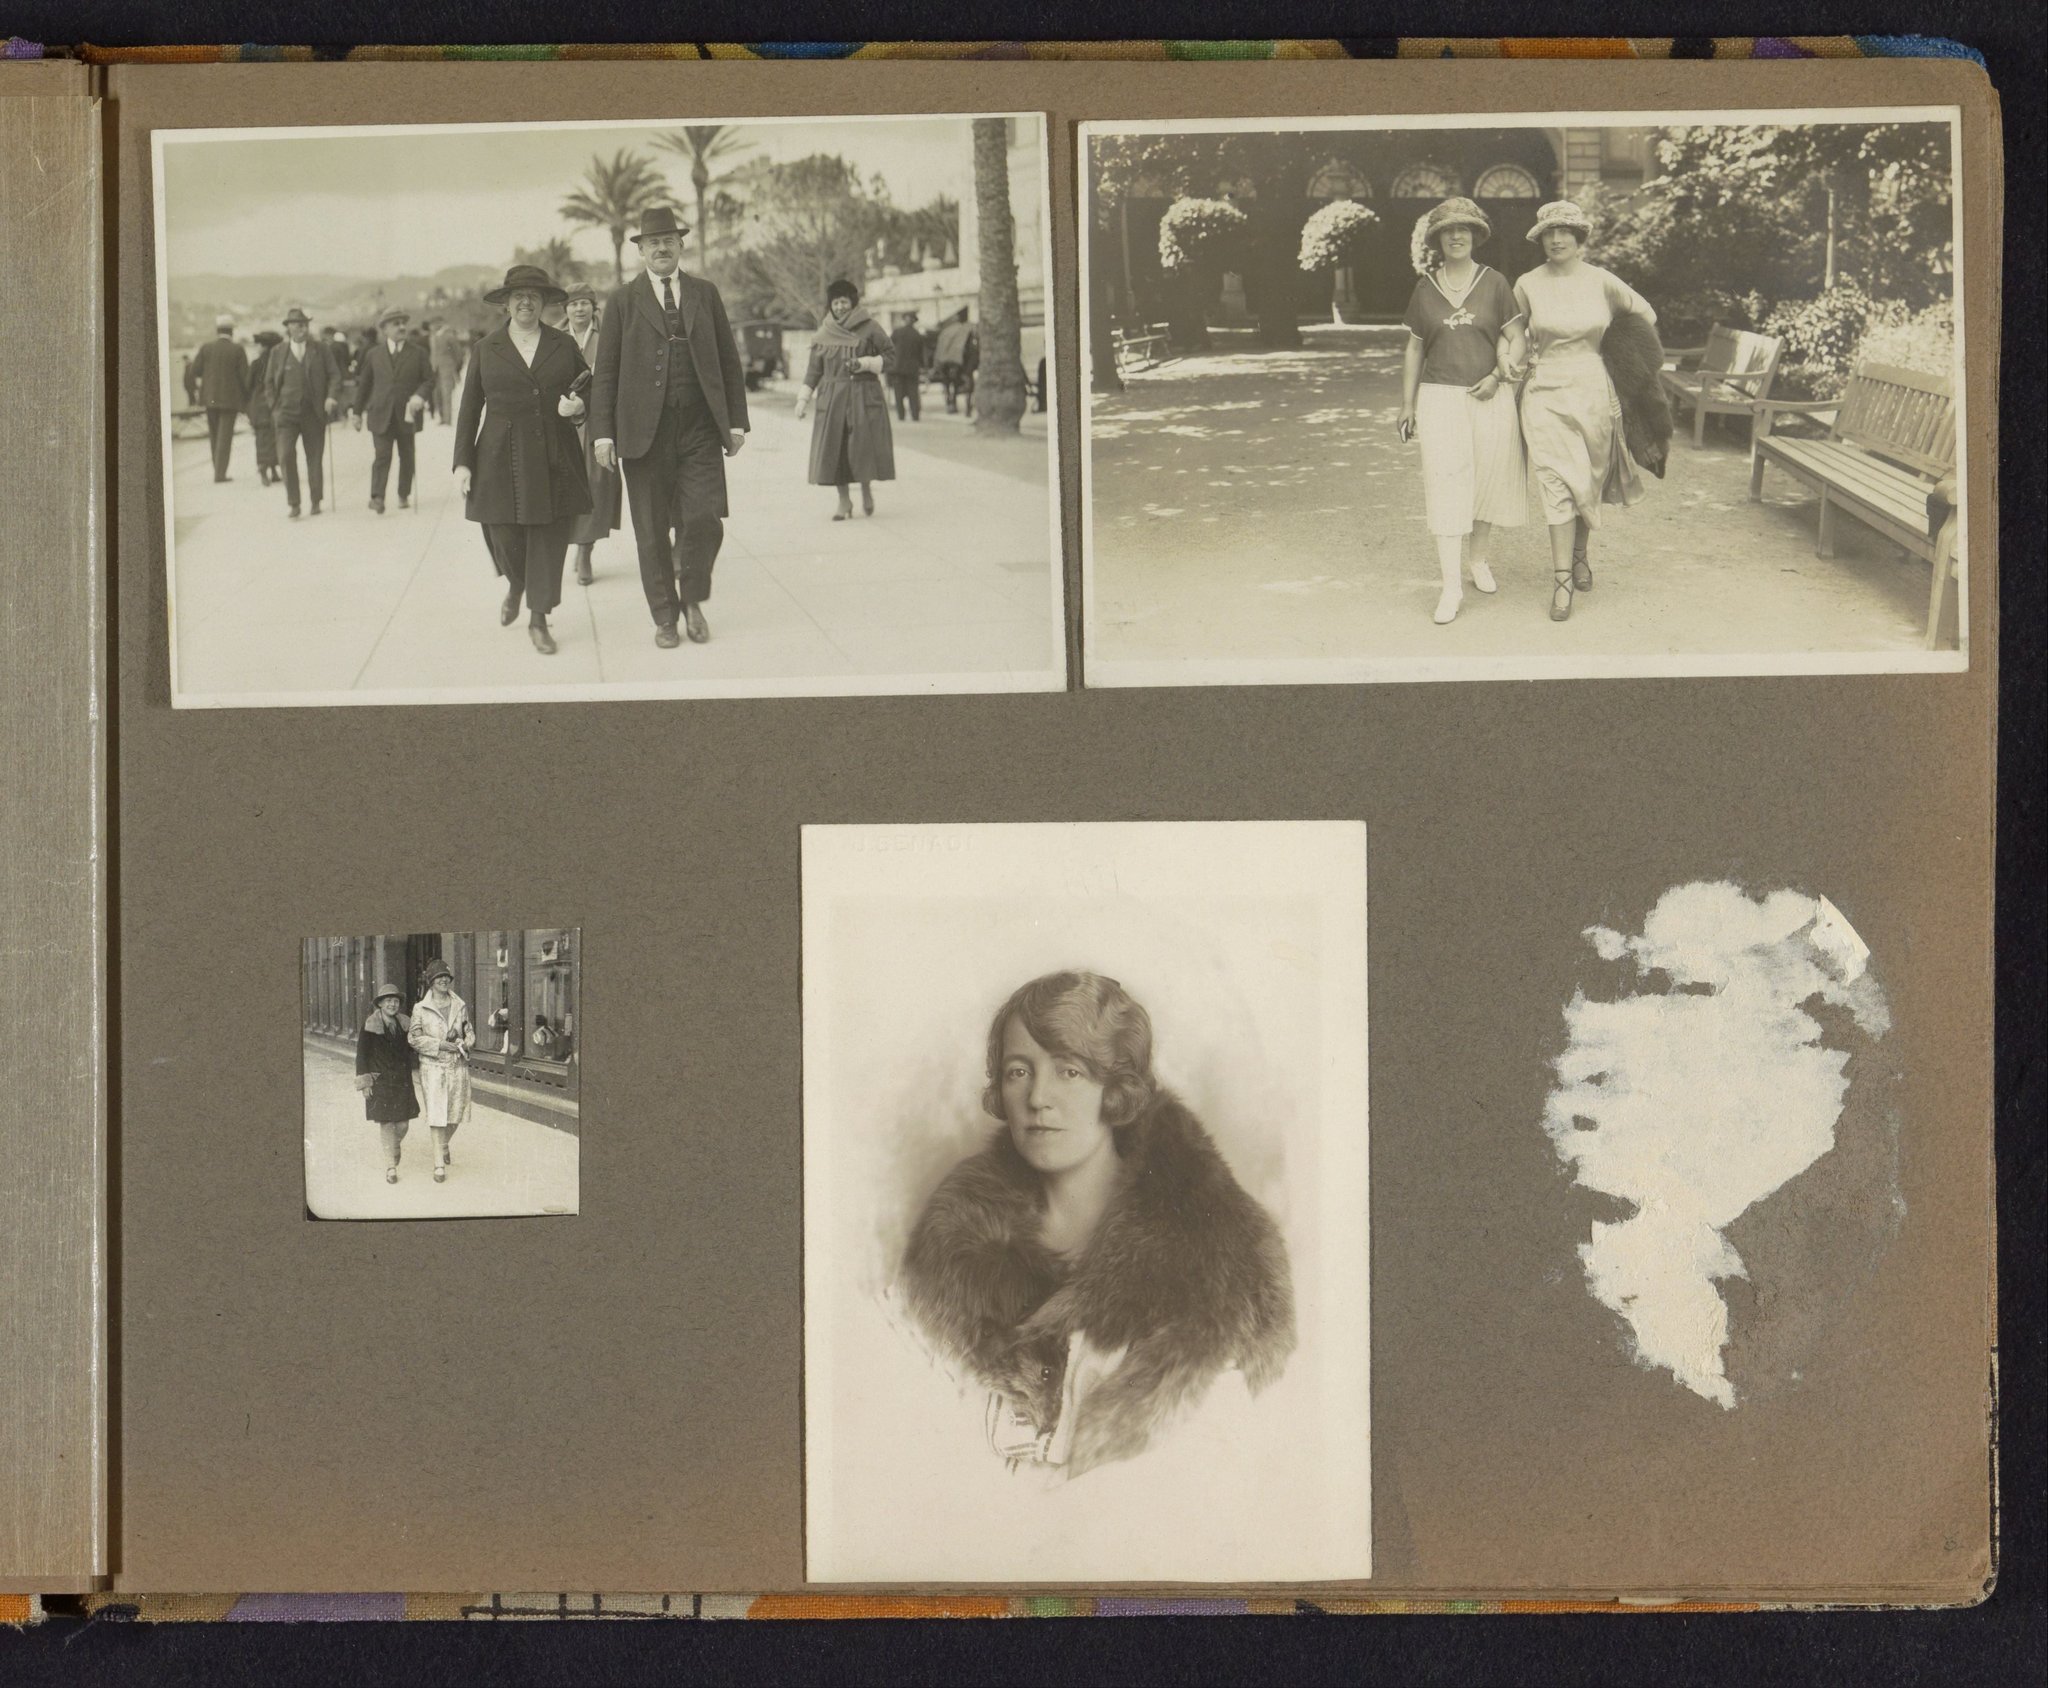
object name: album leaf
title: Wandelende mensen en een portret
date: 1900-1925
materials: cardboard, photographic support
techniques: gelatin silver print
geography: europe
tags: adult woman, adult man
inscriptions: name: ‘J Benade’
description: Albumblad met foto's van wandelende volwassenen en een kind, vermoedelijk in Zuid-Europa. Ook een portret van een vrouw met een bontkraag (een 'vos'). Onderdeel van Fotoalbum van een onbekende Nederlandse familie met connecties in Suriname en Nederlands-Indië (1).